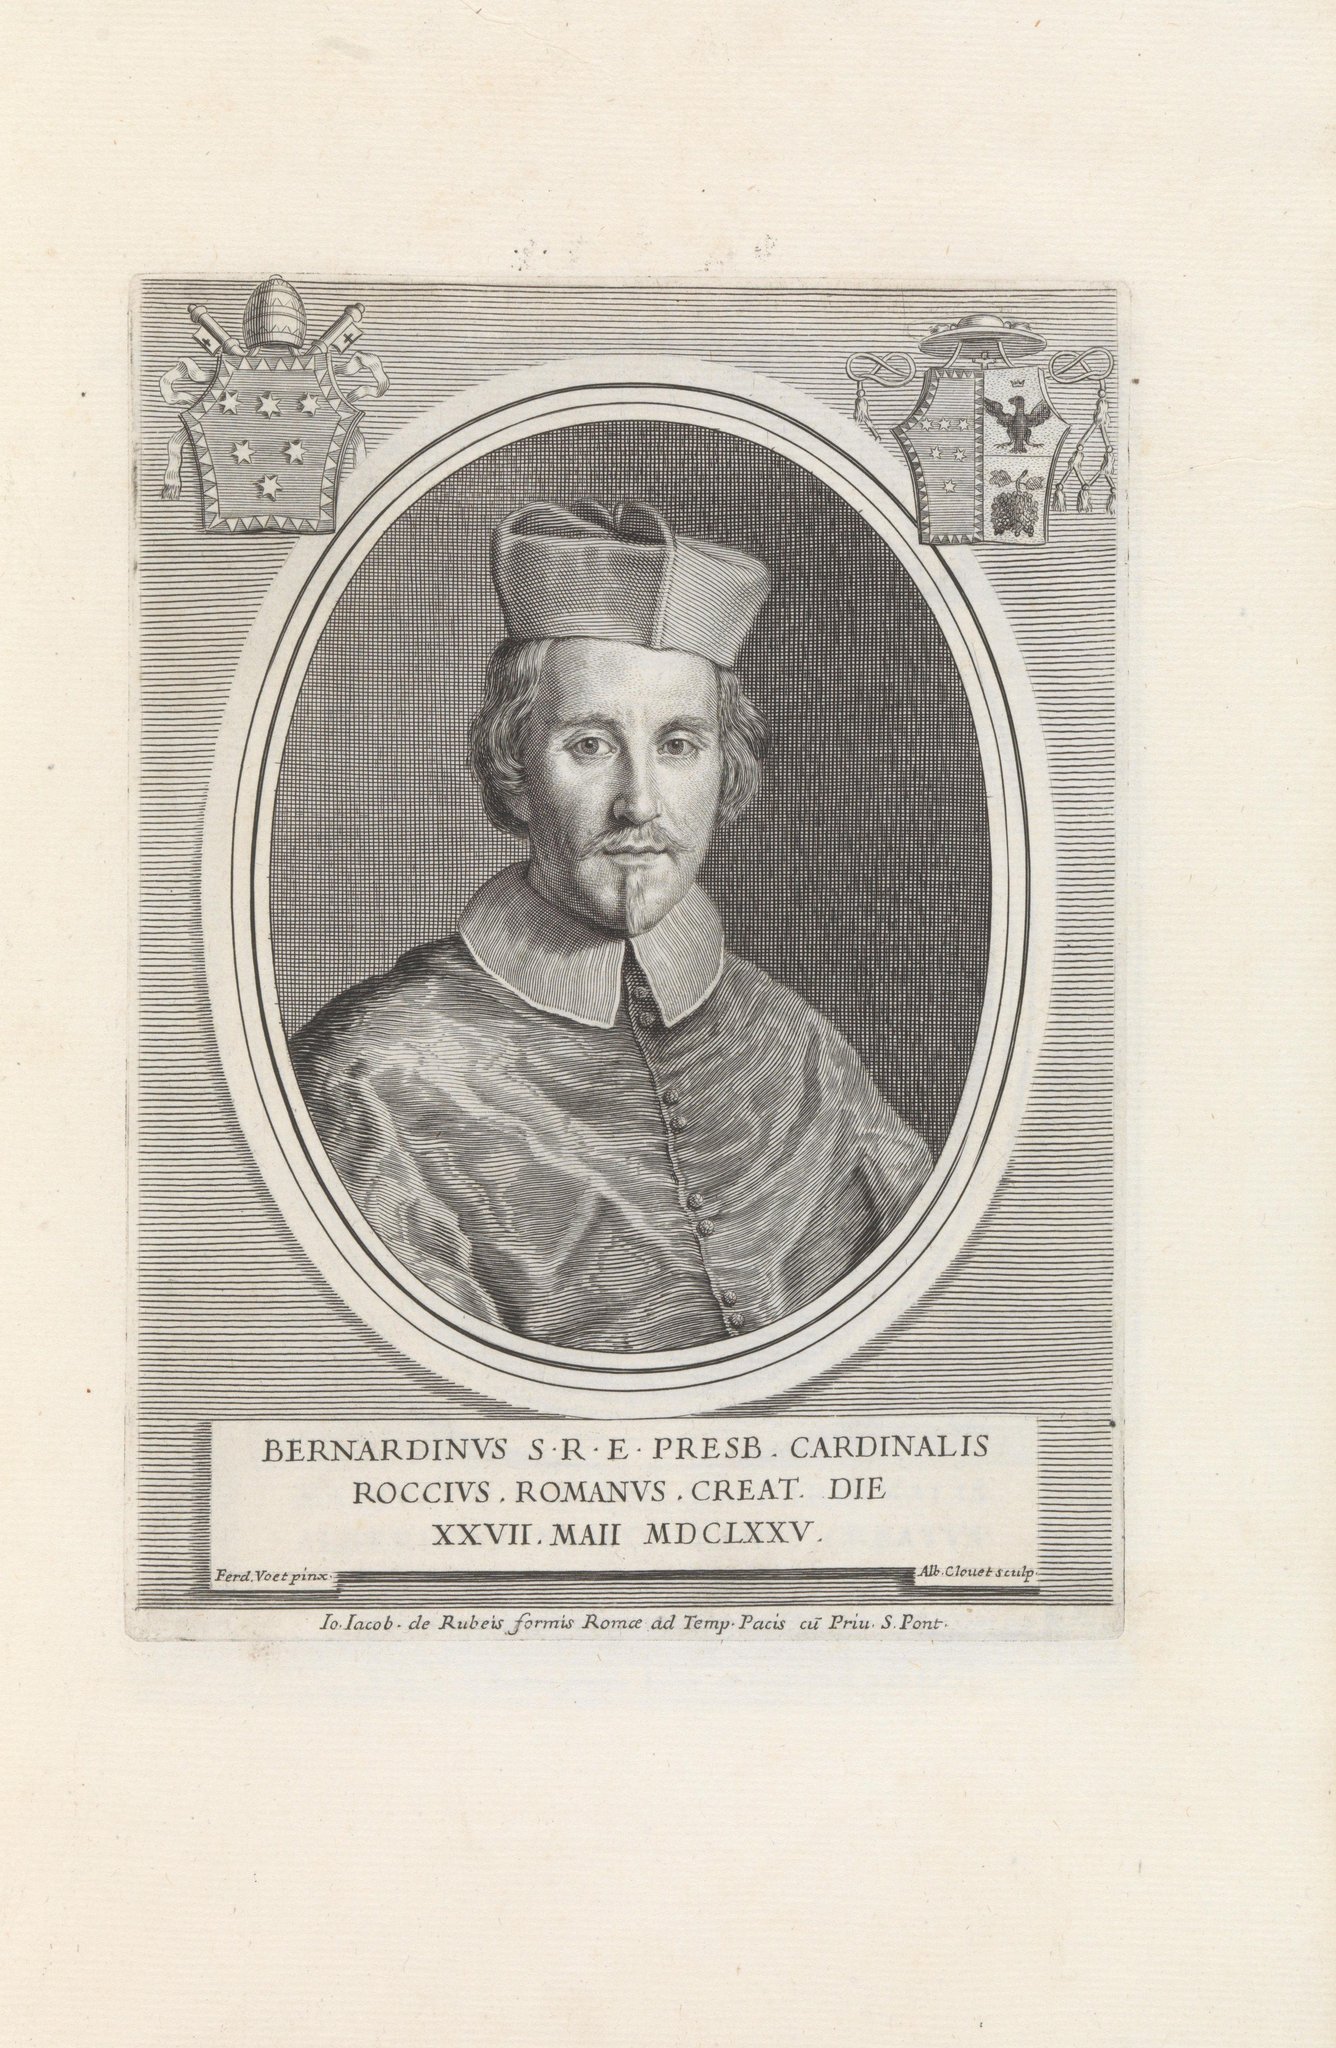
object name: album leaf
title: Effigies Nomina et Cognomina S.D.N. Alexandri Papae VII et RR. DD. SRE. Cardd (...).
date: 1675-1679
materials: paper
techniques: engraving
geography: rome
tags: bernardino rocci, cardinal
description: Portret van kardinaal Bernardino Rocci. Linksboven het wapen van paus Clemens X en rechtsboven het wapen van de kardinaal. Onderaan een onderschrift in het Latijn. De prent maakt deel uit van een album.